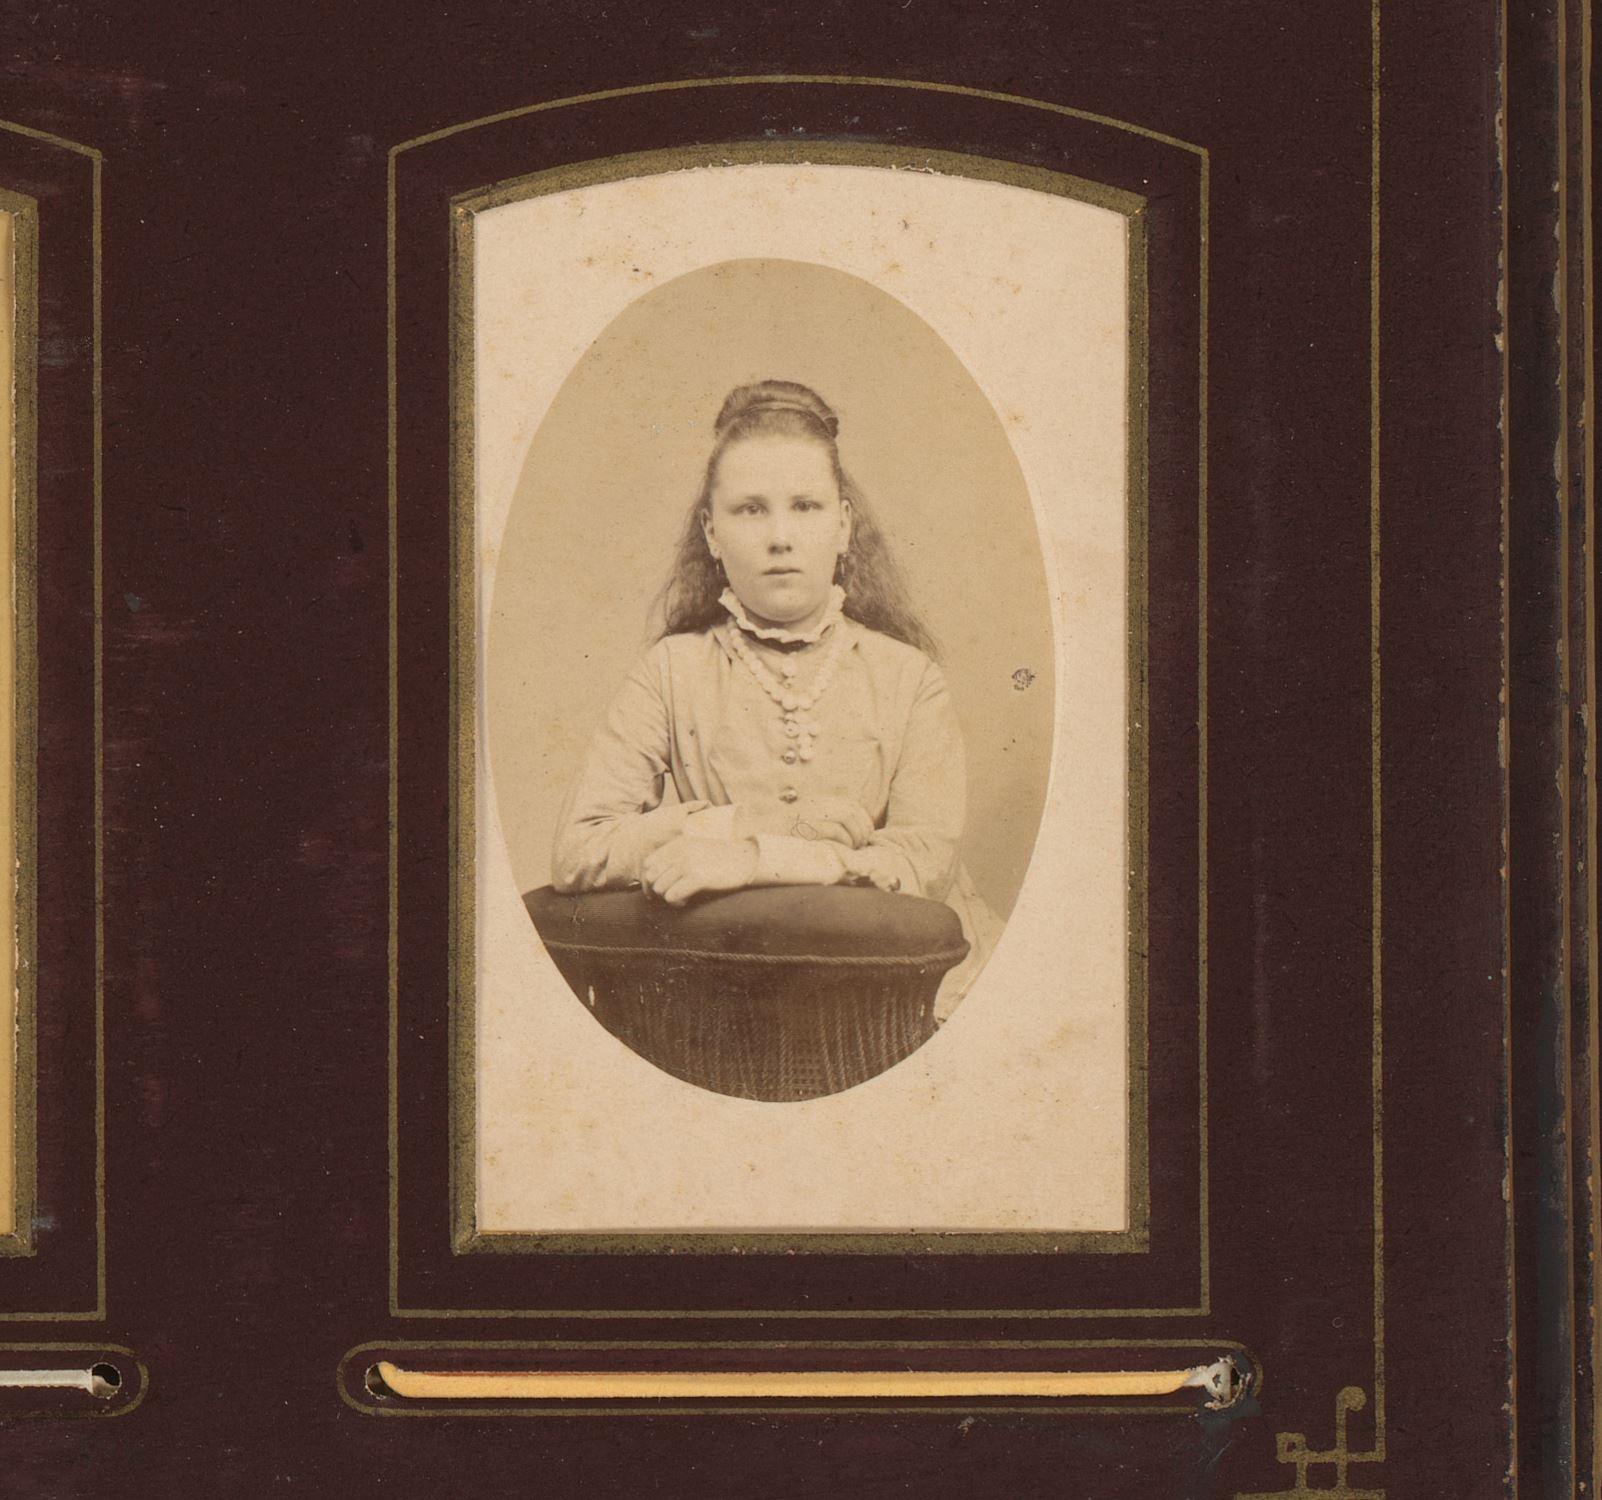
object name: carte de visite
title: Portret van een meisje, leunend op een stoel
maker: jacques chrispijn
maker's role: fotograaf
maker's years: 1851-1927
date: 1874-1877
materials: cardboard, photographic support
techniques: albumen print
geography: alkmaar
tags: historical persons - bb - woman, girl (child between toddler and youth), chair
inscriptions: inscription: ‘Photographisch/ Atelier/ van/ J. CHRISPIJN/ Langestraat/ Zuidzijde A No. 98/ Alkmaar’